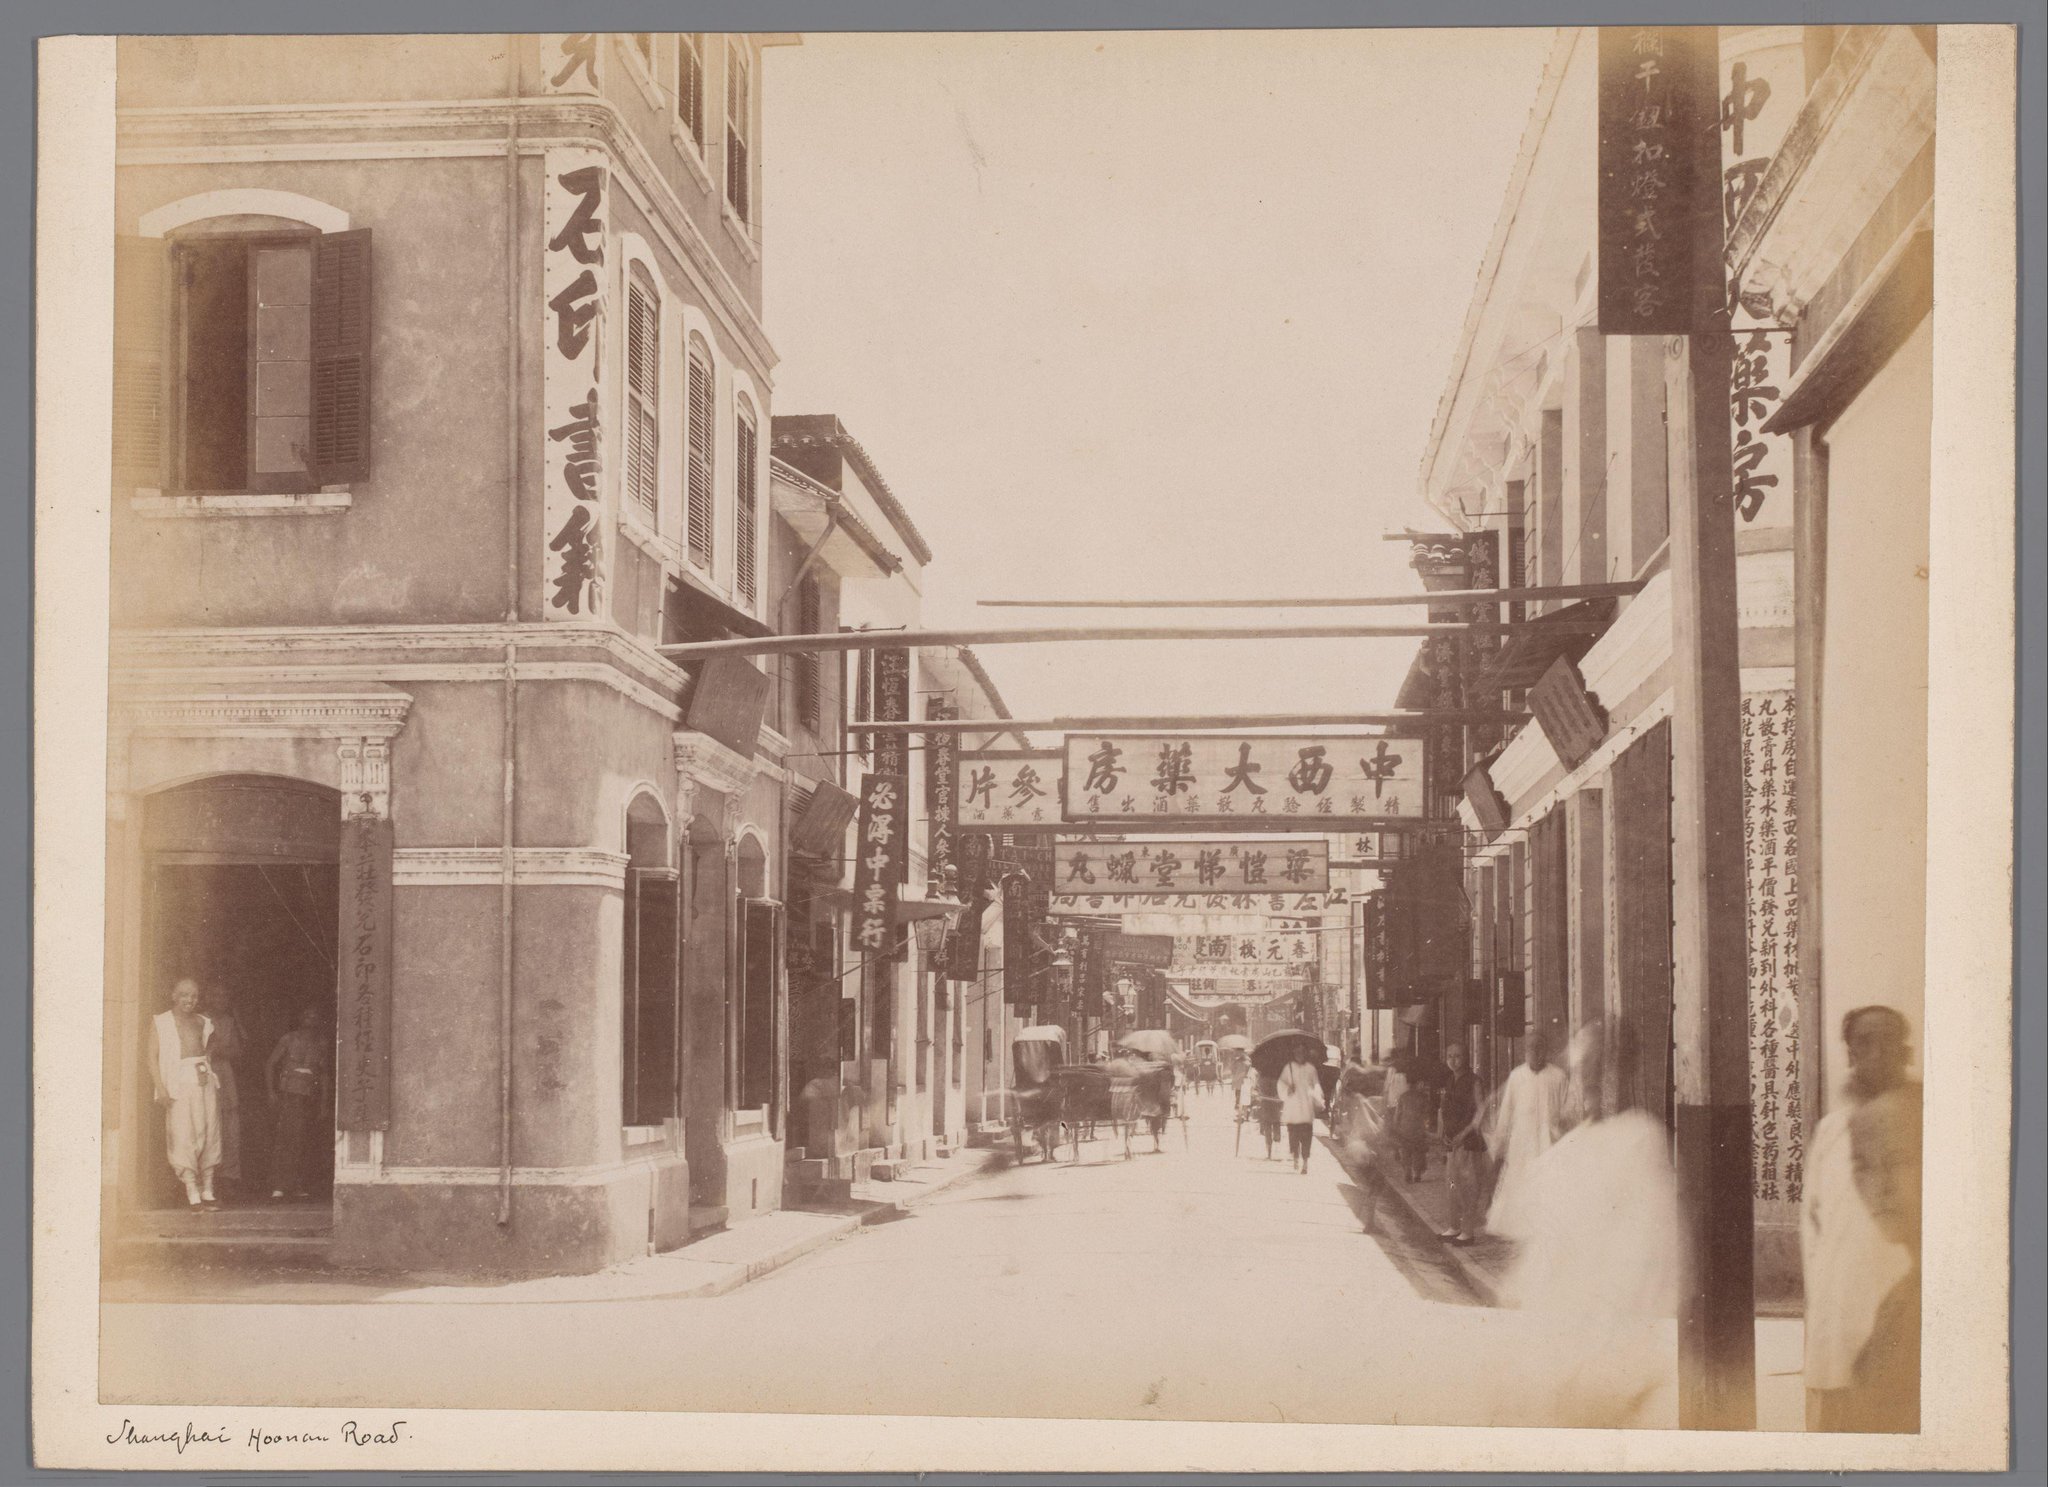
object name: photograph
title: Straatgezicht van Hoonan Road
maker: Anonymous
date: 1850-1900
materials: cardboard, photographic support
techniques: albumen print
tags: street (+ city(-scape) with figures, staffage)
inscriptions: annotation: ‘Shanghai-Hoonan Road’